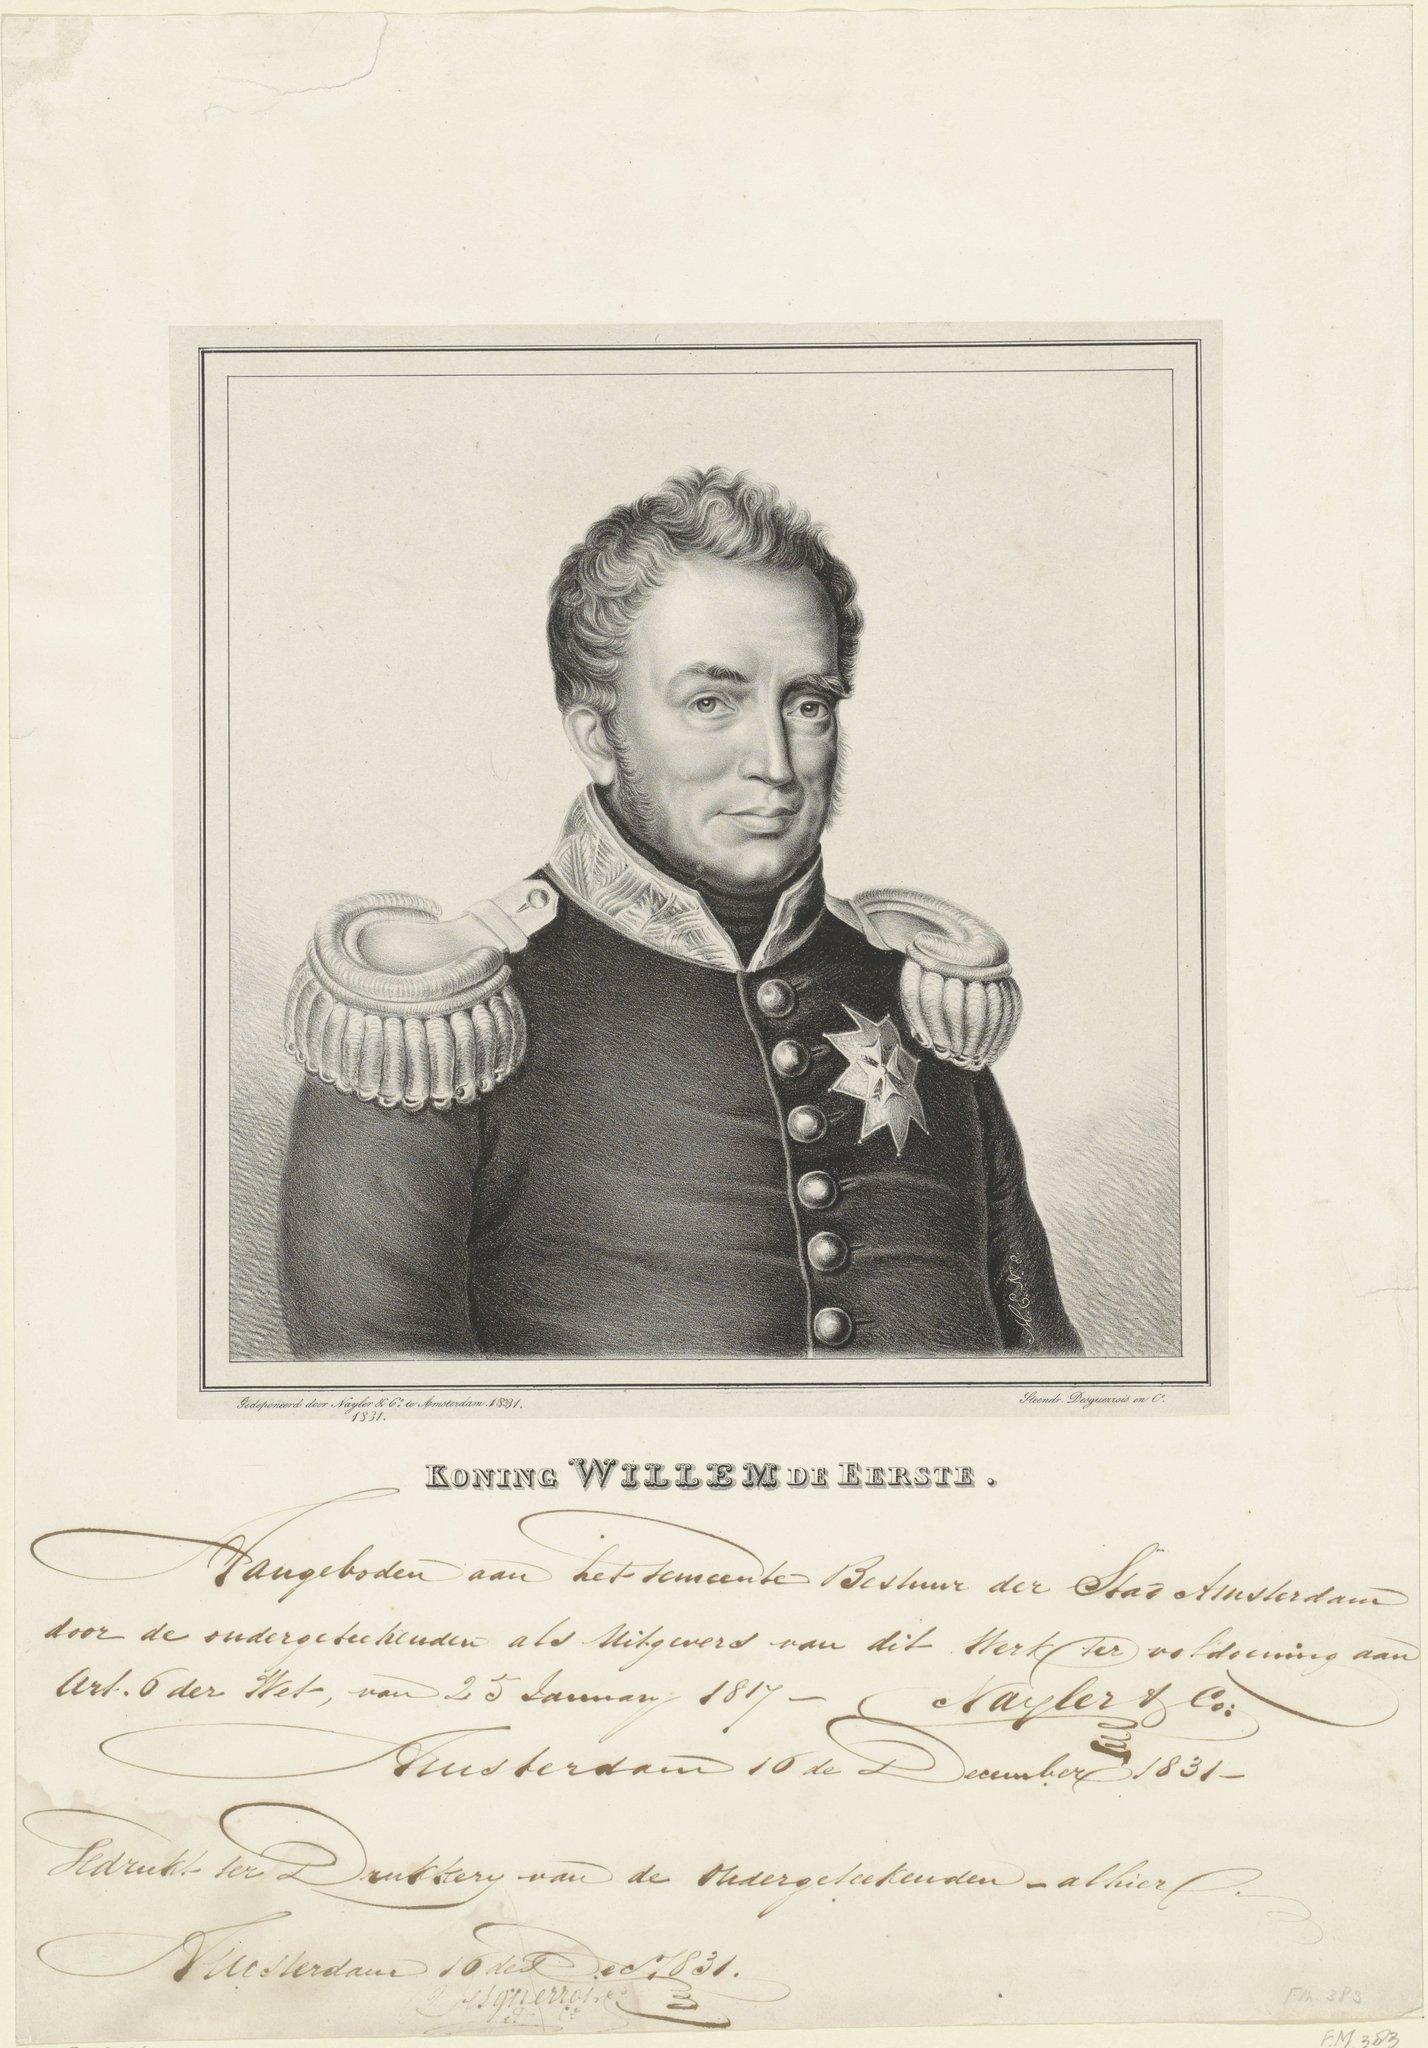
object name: print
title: Portret van Willem I Frederik, koning der Nederlanden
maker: maria elisabeth liernur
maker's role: print maker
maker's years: 1802-1874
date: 1831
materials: paper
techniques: lithograph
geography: amsterdam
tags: the hague, berlin, william i of the netherlands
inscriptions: : ‘Aangeboden aan het Gemeente Bestuur der Stad Amsterdam door de ondergeteekenden aks uitgevers van dit Werk ter voldoening aan Art. 6 der Wet, van 25 January 1817 - Nayler & Co: Amsterdam 16de December 1831 / Gedrukt ter Drukkerij van de ondergeteekenden - alhier. Amsterdam 16de Dec 1831. Desguerrois et Co’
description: De hier vermelde titel verwijst naar de hoogst verkregen titel van de geportretteerde, niet per se naar de titel die de geportretteerde op deze voorstelling draagt.